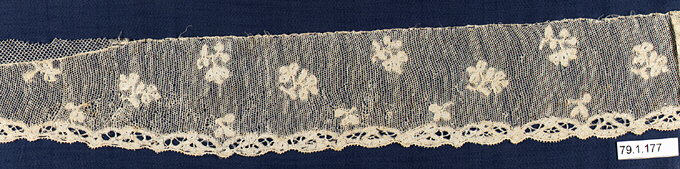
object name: strip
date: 1767-1800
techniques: lace